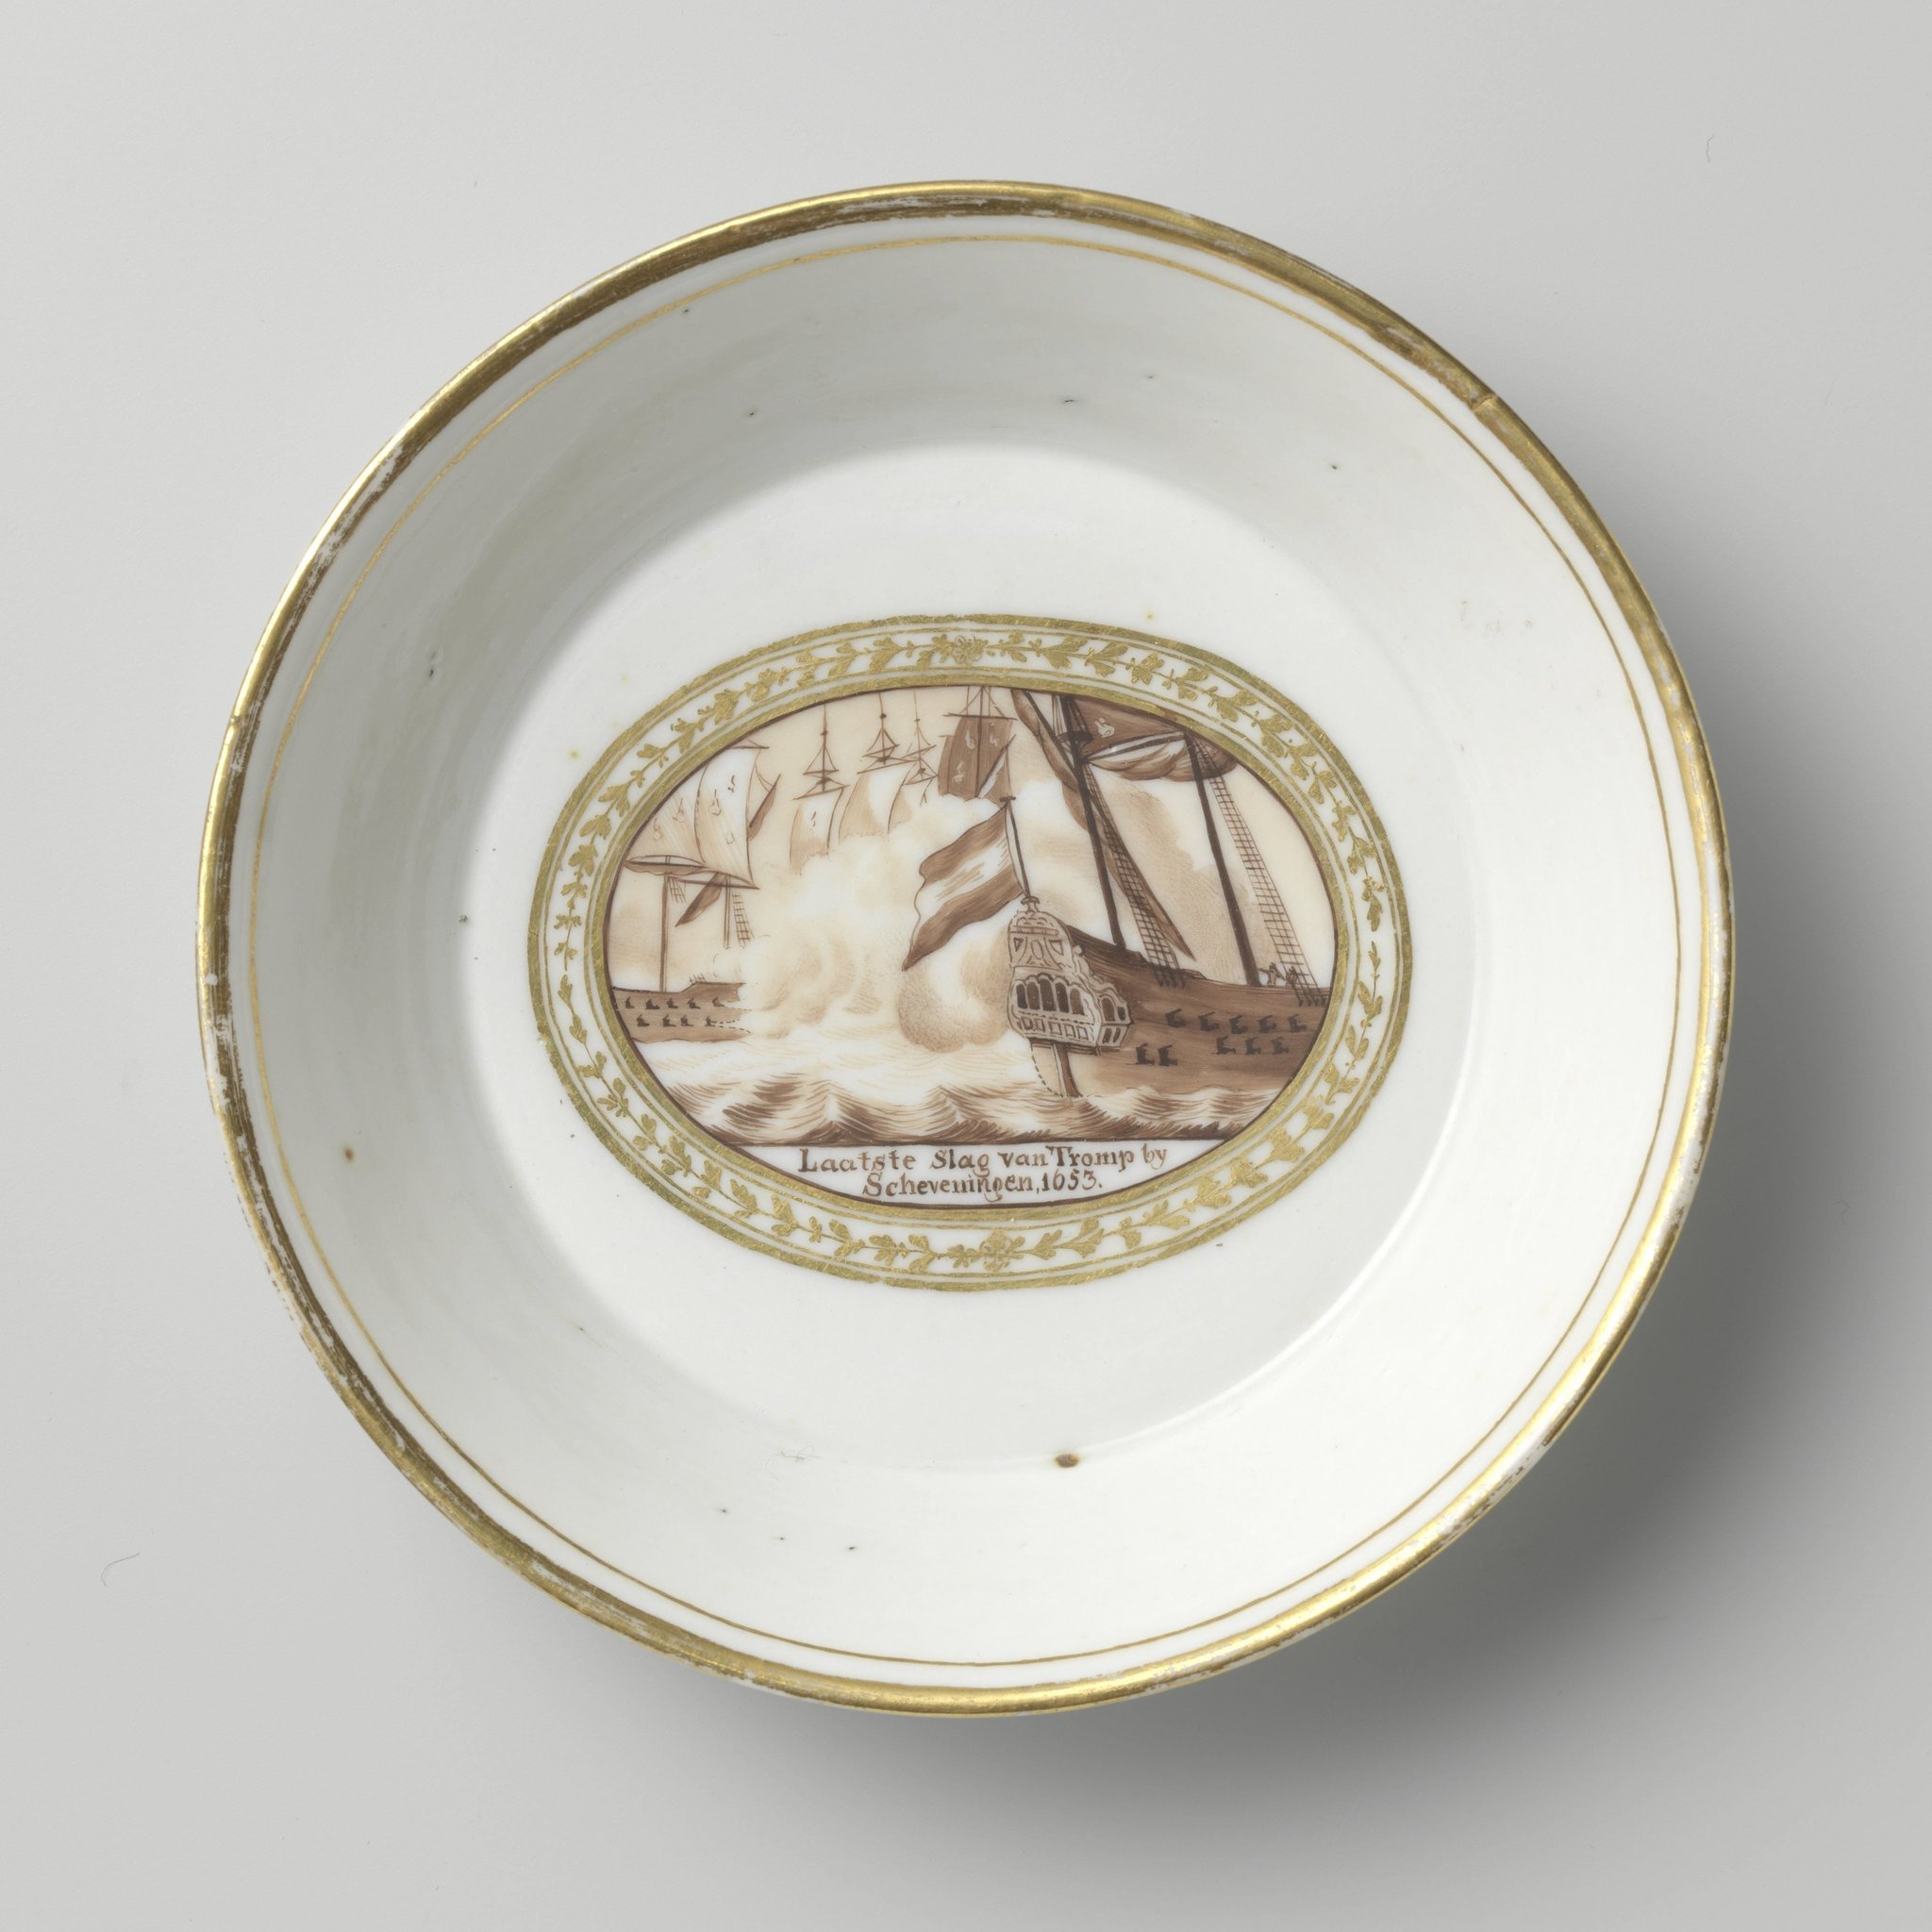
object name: service set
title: Saucer with an image of the final battle of Maarten Tromp at Scheveningen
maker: Anonymous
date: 1794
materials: glaze, gold, paint, porcelain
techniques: firing, forming, gilding, turning, vitrification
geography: schwarzburg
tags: maarten harpertszoon tromp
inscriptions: mark: ‘103-N/ 12’, inscription: ‘LAATSTE SLAG VAN TROMP BY SCHEVENINGEN, 1653’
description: Schotel, één van een serie van tien,onderdeel van een servies met in bruin geschilderde medaillons waarin historische voorvallen en portretten van personen uit de vaderlandse geschiedenis. De schotel is gedecoreerd met een voorstelling van de laatste slag van Maarten Harpertszoon Tromp bij Scheveningen in 1653. Gemerkt.